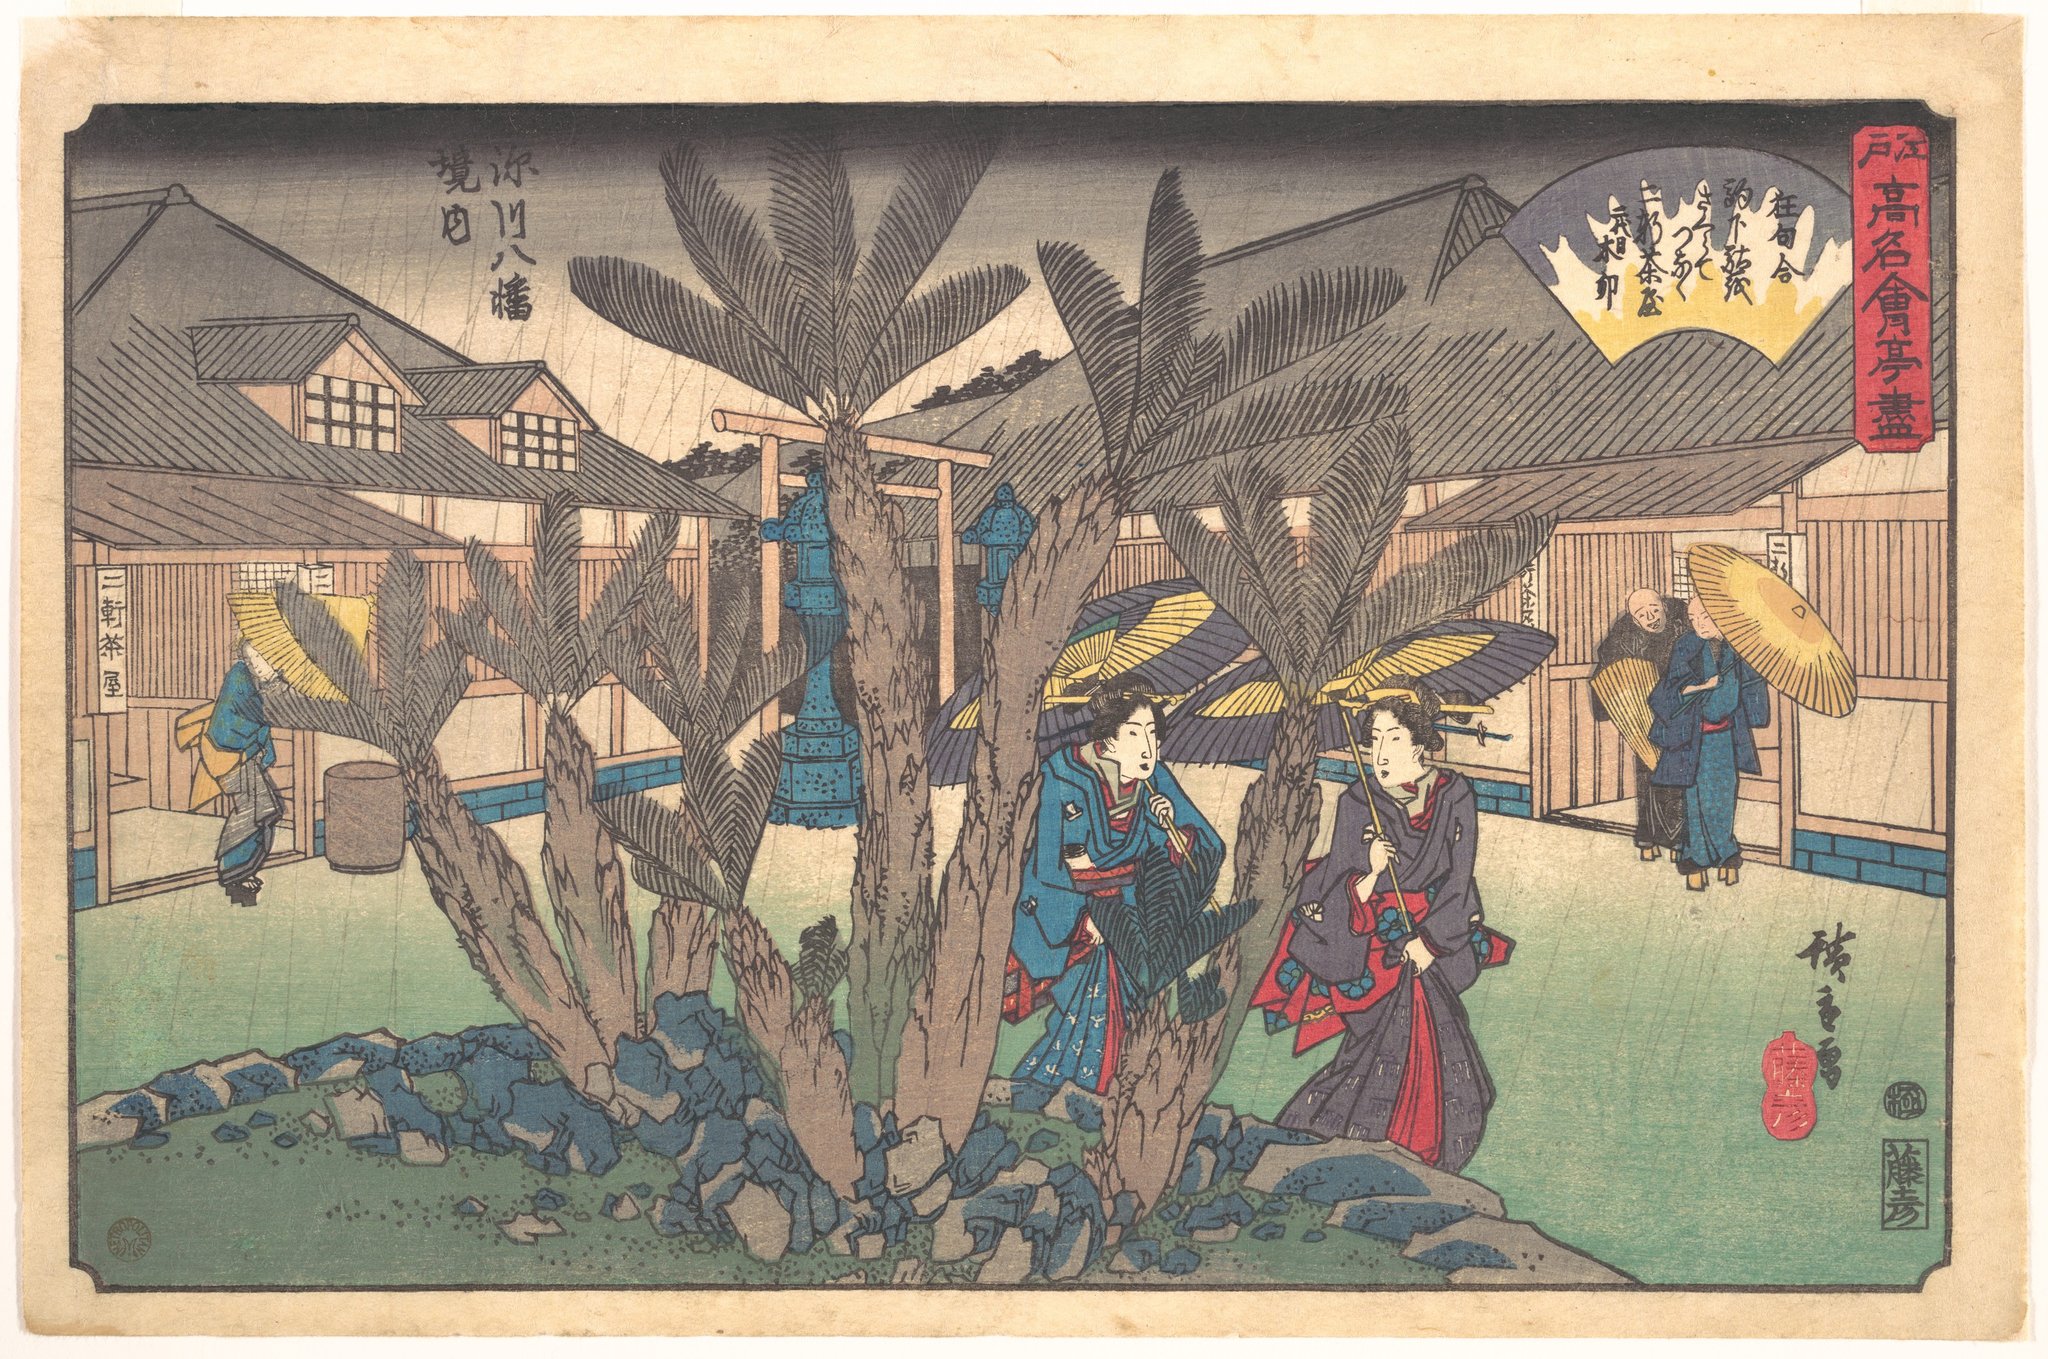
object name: print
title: Tea-house inside Hachiman Shrine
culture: japanese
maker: utagawa hiroshige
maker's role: artist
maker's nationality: japanese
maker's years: 1797-1858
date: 1835-1842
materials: ink, paper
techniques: woodblock print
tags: women,trees,rain,umbrellas,tea houses